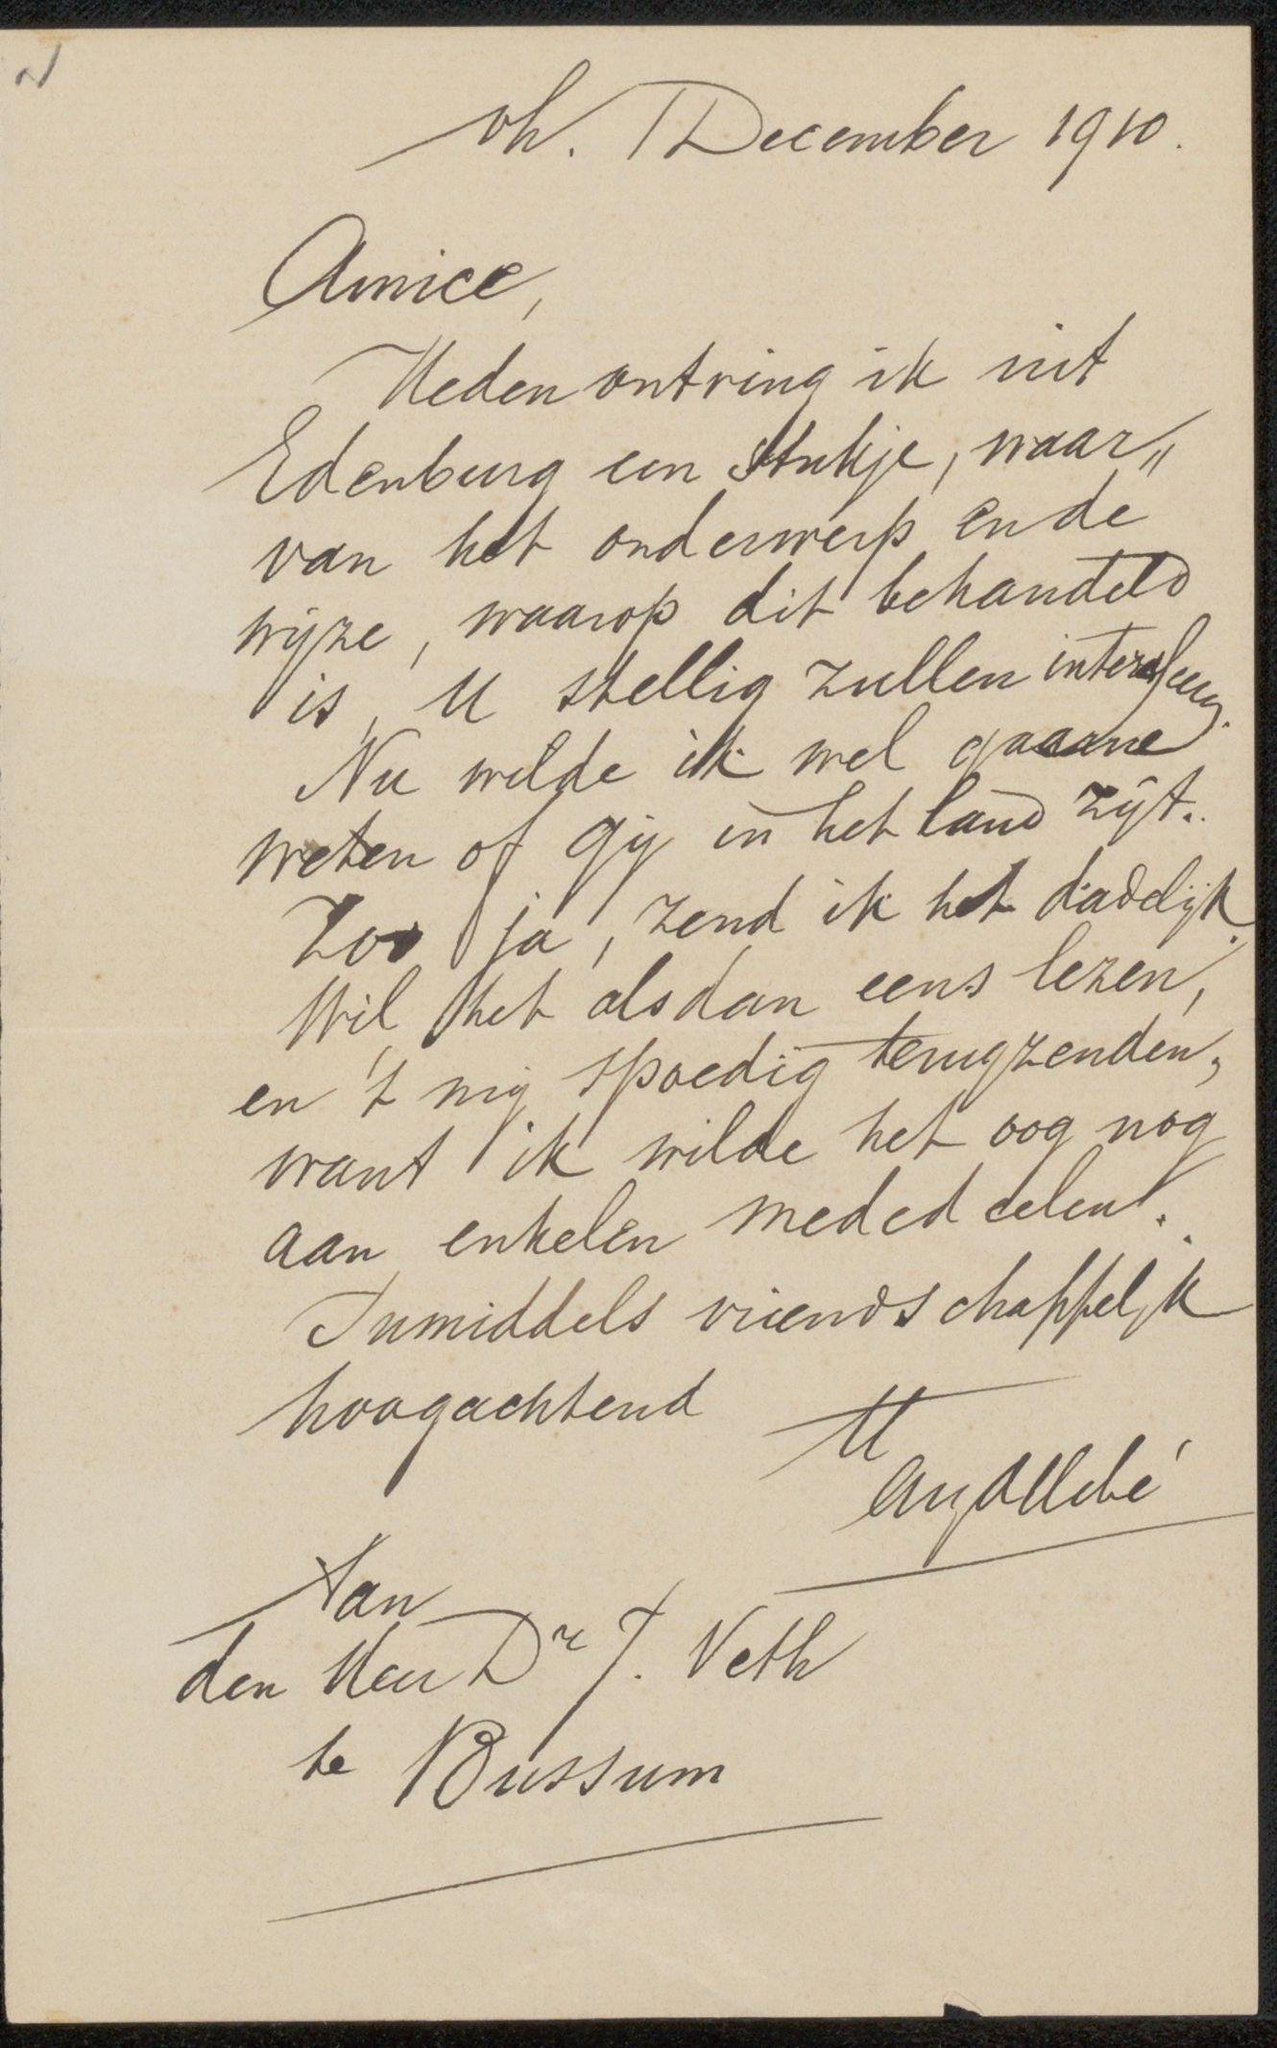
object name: letter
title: Brief aan Jan Veth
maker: august allebé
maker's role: draughtsman, print maker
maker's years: 1838-1927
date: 1910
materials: ink, paper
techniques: pen, writing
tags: dordrecht, amsterdam, painter, print maker, draughtsman, designer, jan veth, printed matter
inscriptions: collector's mark: ‘RPK’